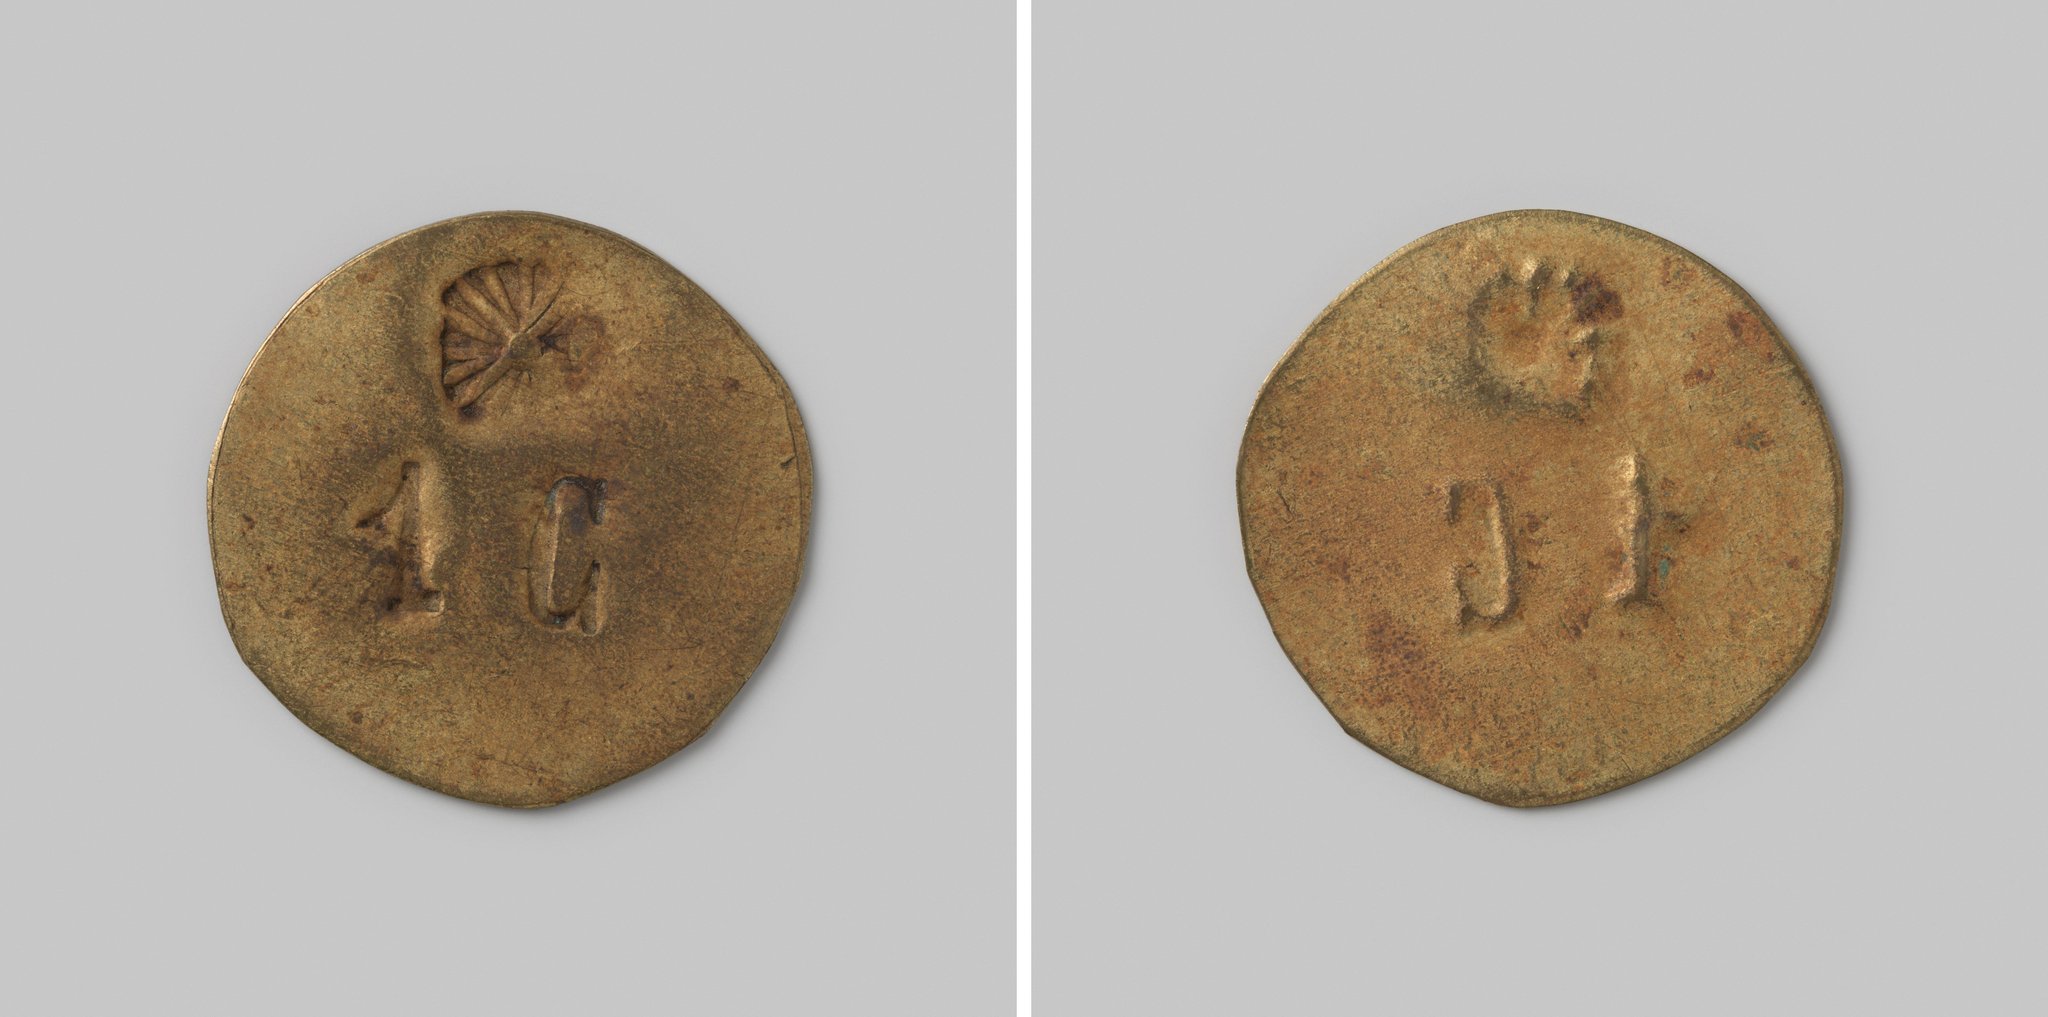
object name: history medal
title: Betaalpenning van 1 cent van de Coöperatieve Winkelvereeniging Eendracht Maakt Magt te Hilversum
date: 1875-1900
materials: brass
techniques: printing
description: Rond messing plaatje met inwaartse instempelingen (ster) / 1 C